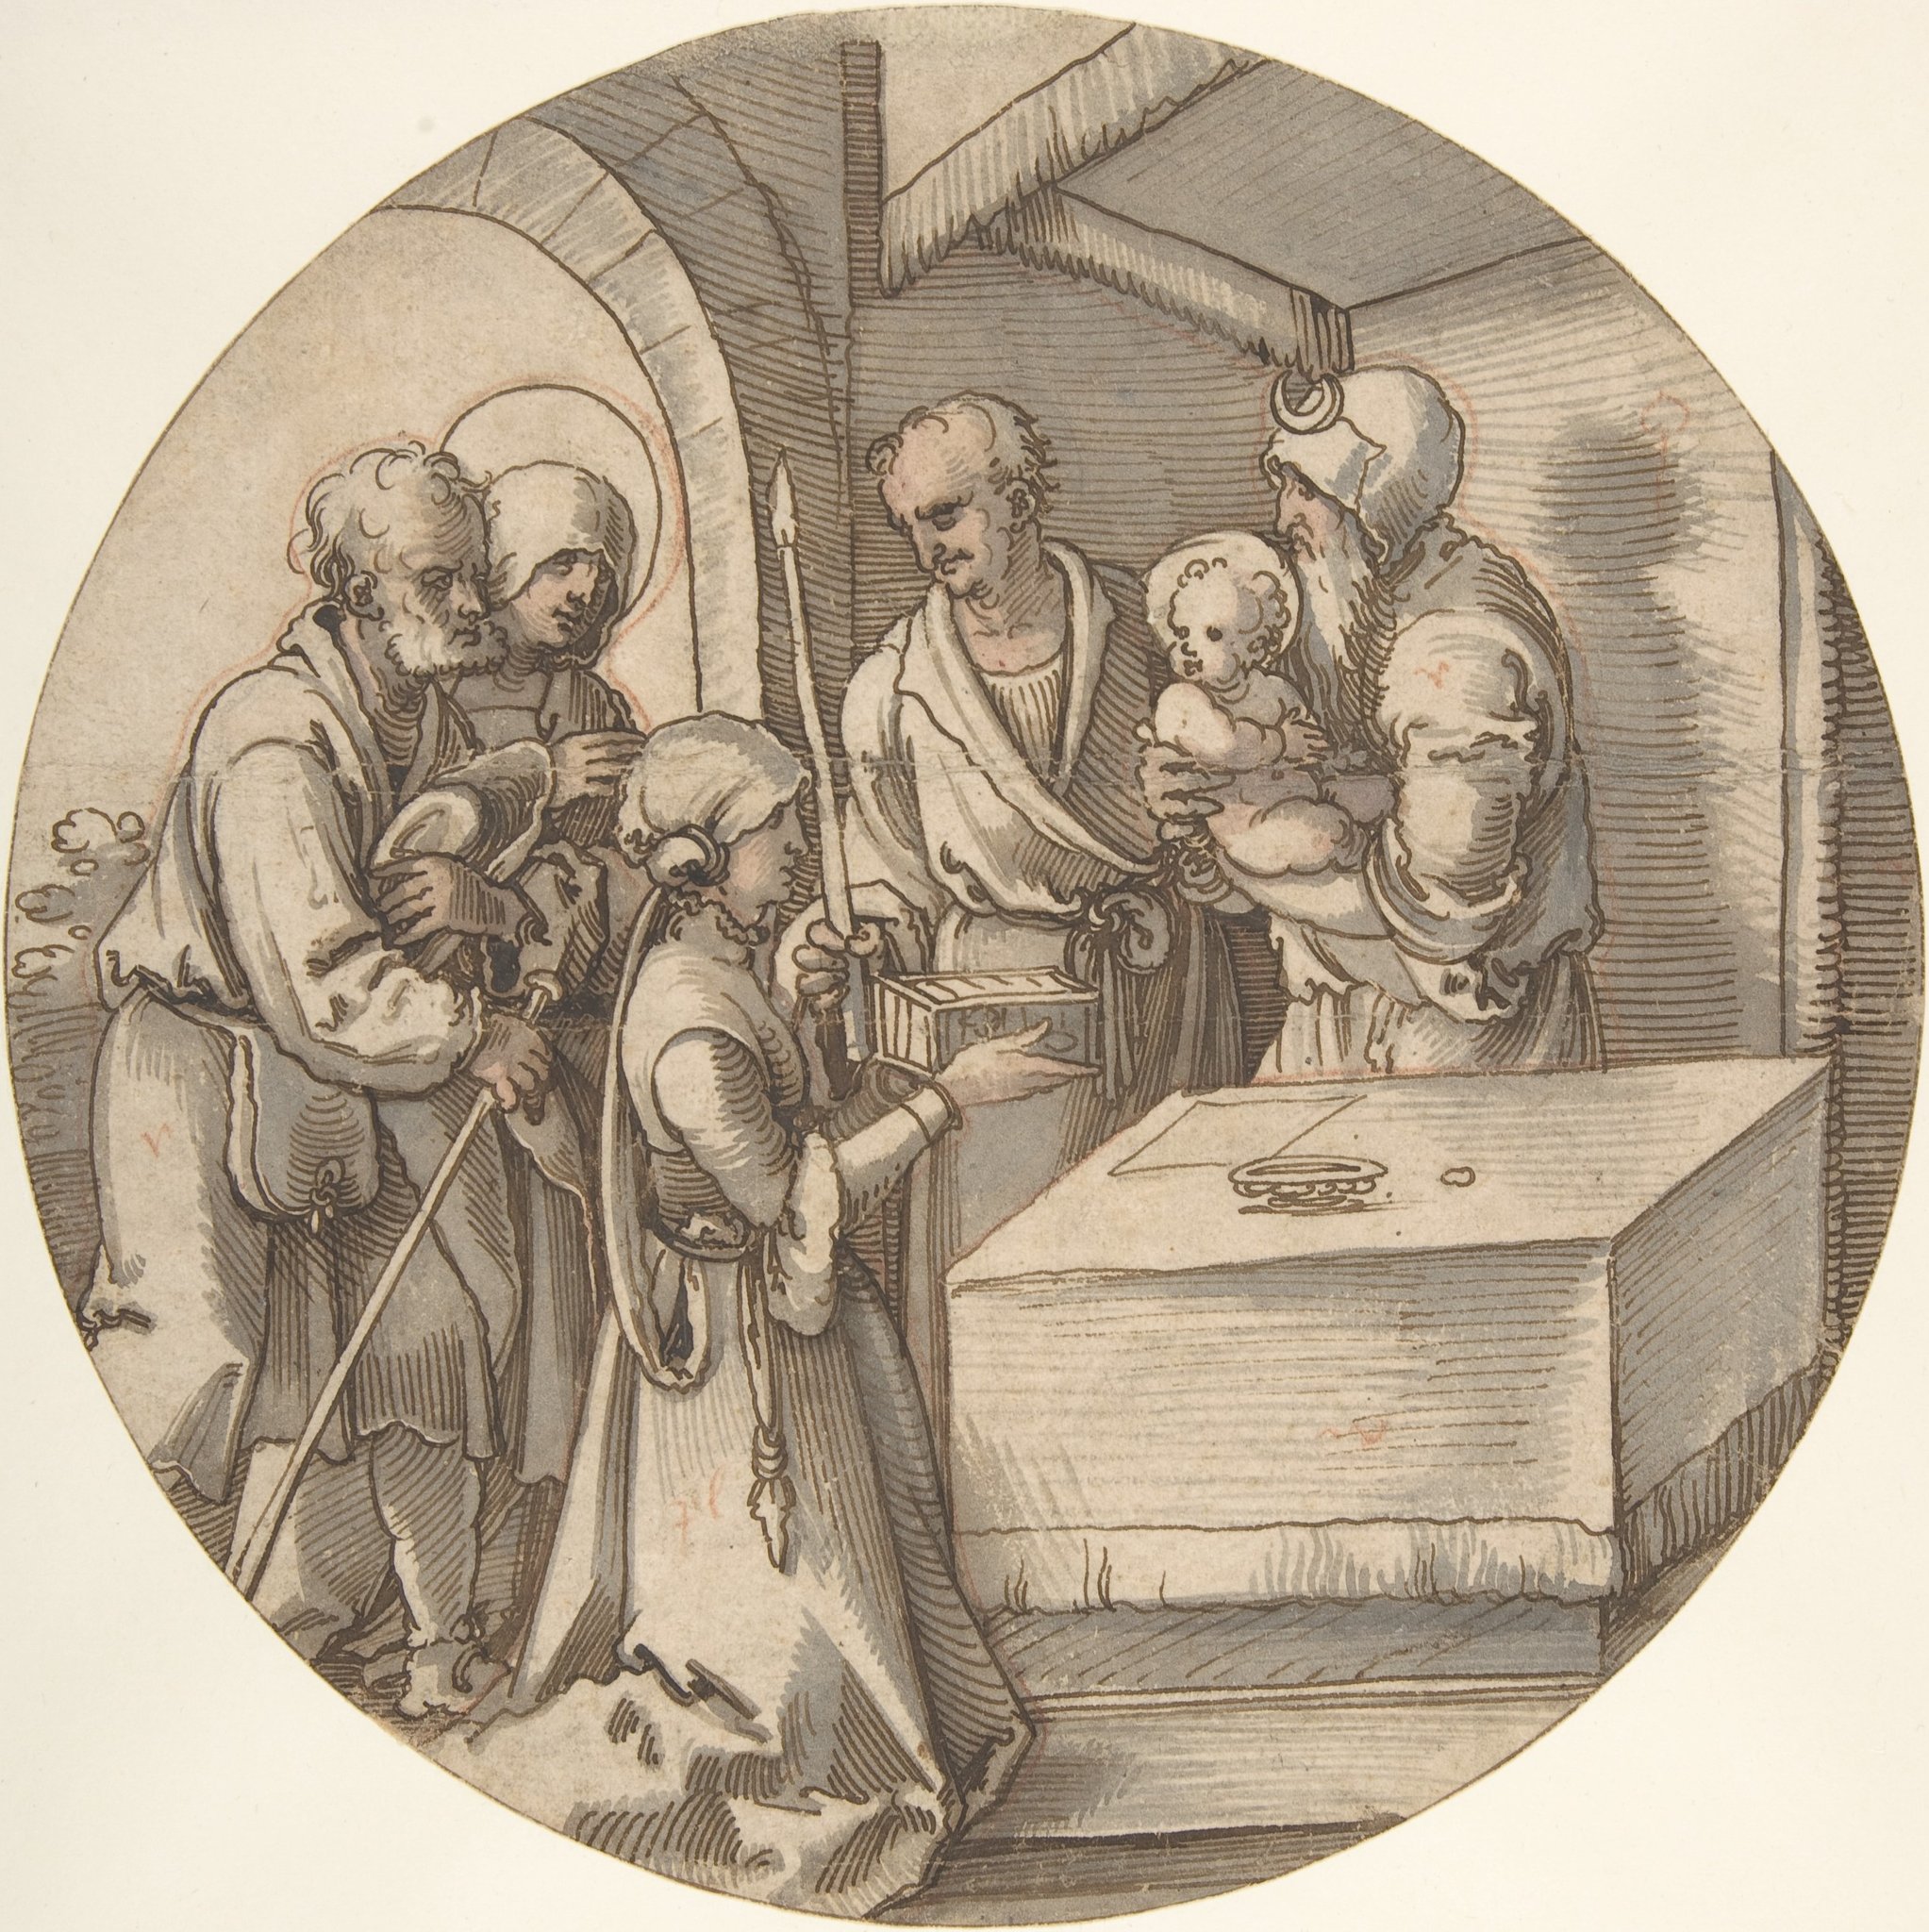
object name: drawing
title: The Presentation of the Infant Jesus in the Temple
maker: sebald beham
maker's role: artist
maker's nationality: german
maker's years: 1500-1550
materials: chalk, ink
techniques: pen, wash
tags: temples,men,women,virgin mary,jesus